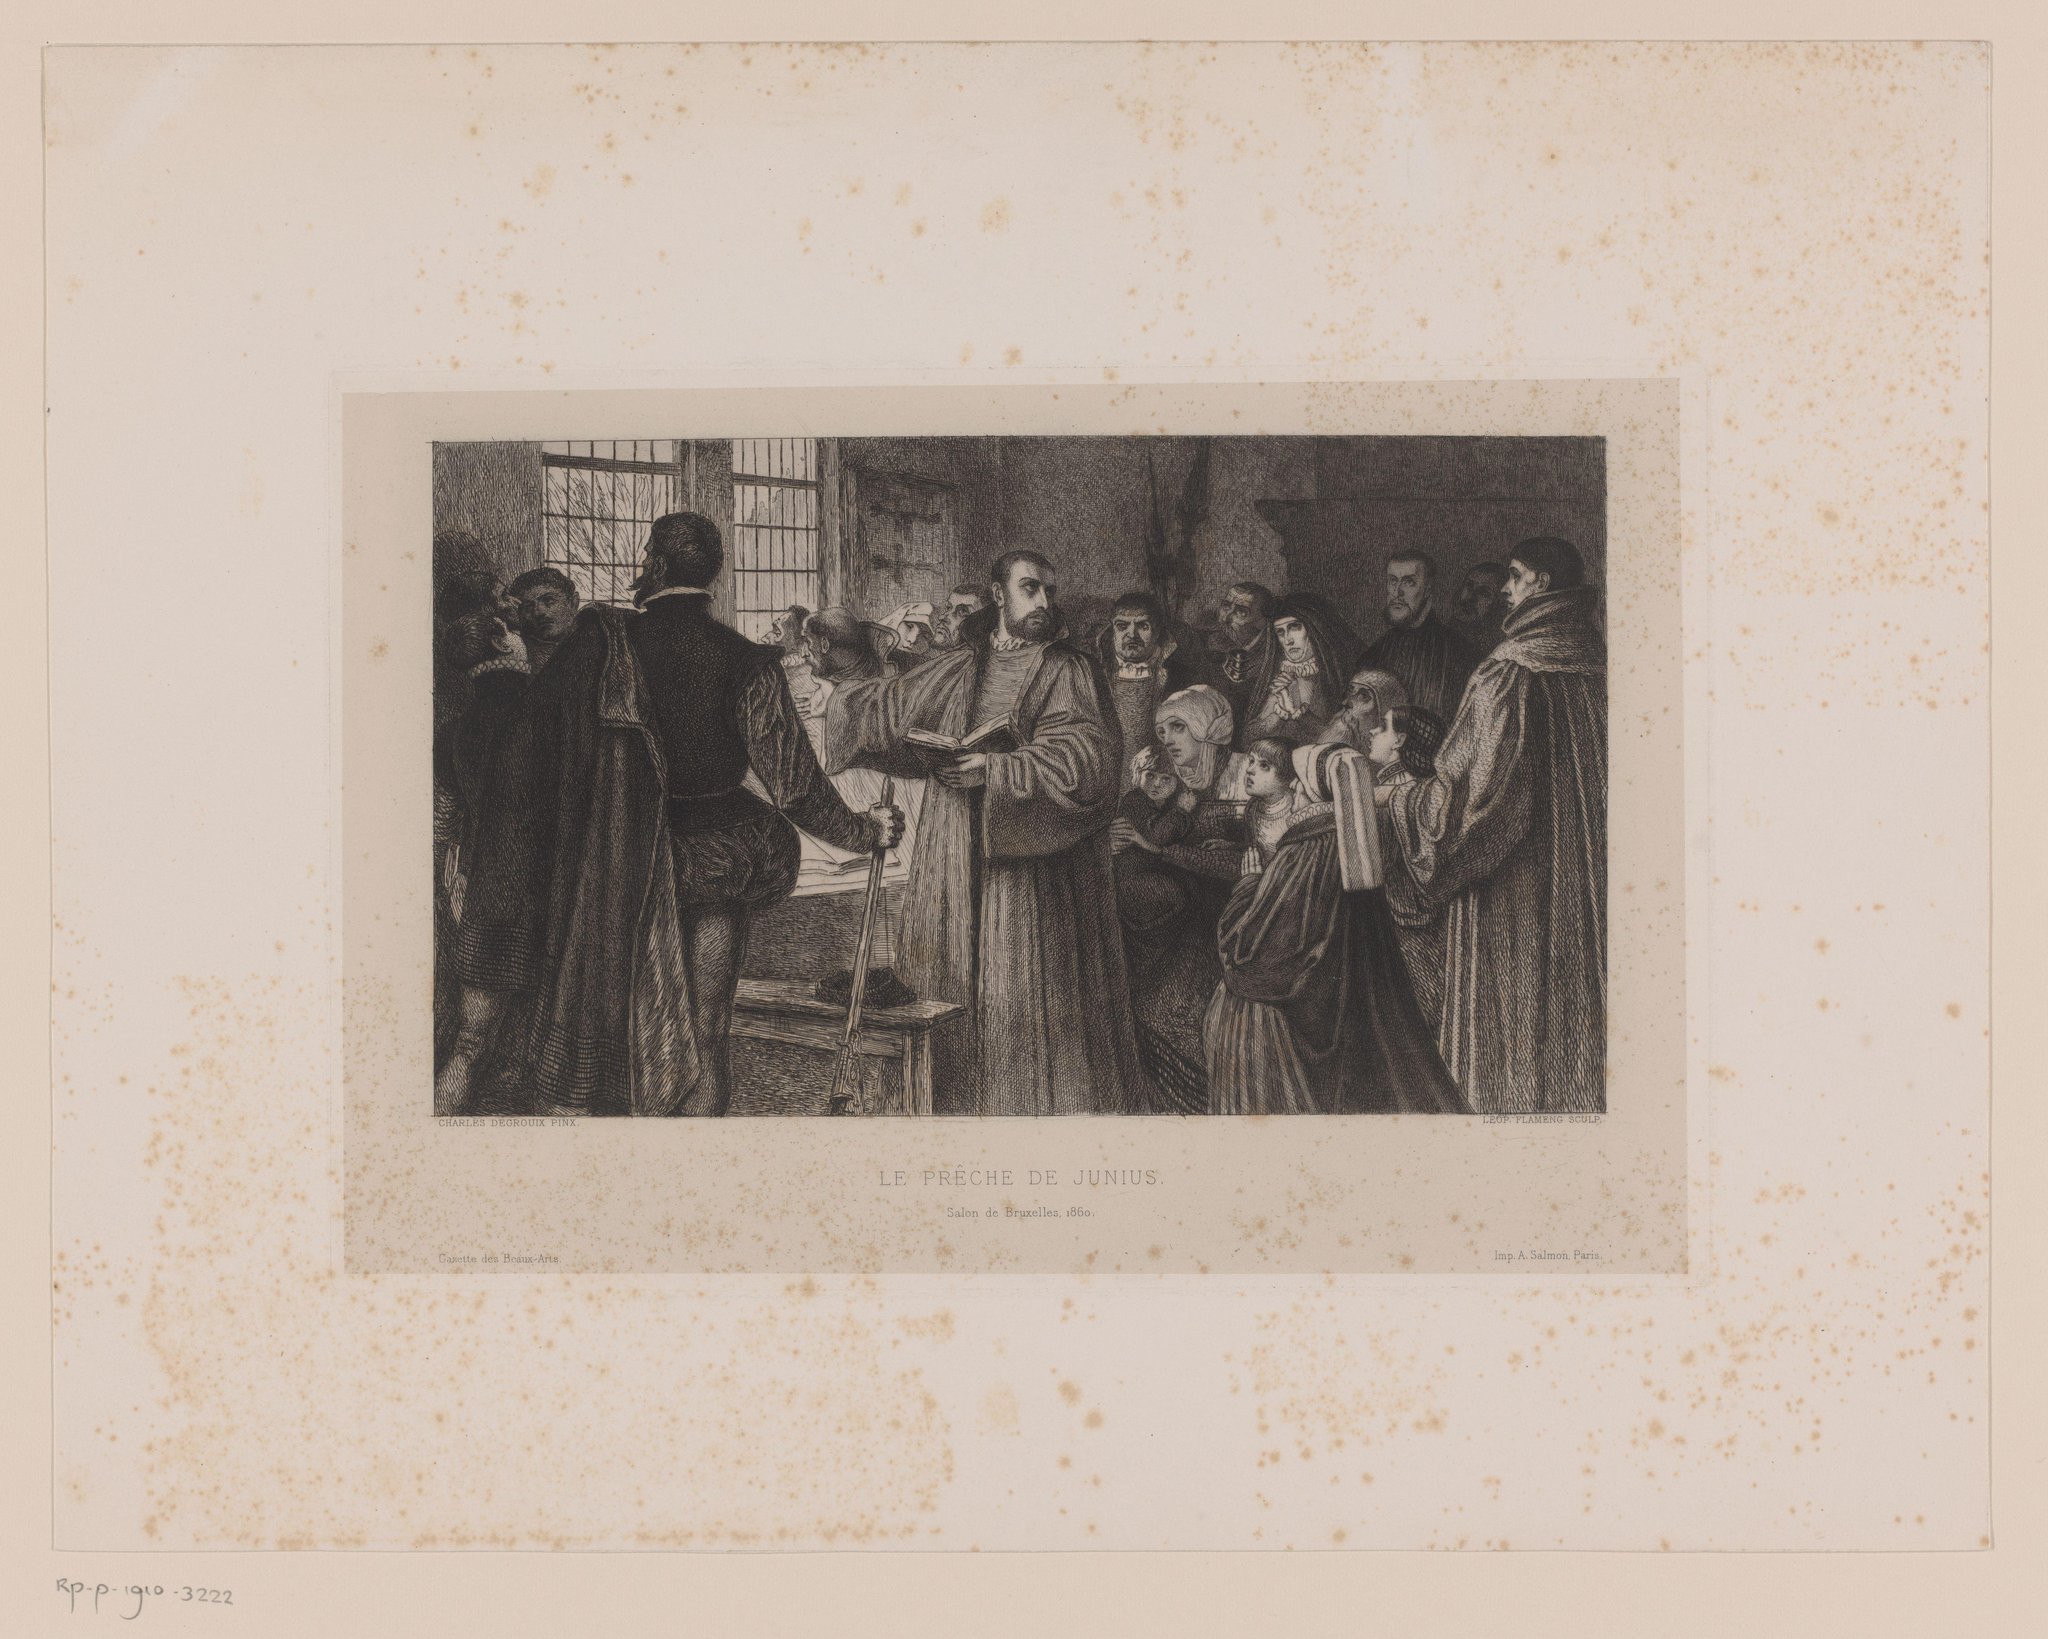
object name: print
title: Fanciscus Junius predikt heimelijk de hervorming in Antwerpen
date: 1860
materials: paper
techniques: etching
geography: paris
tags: franciscus junius (1624-1660), reformation (roman catholic church vs. protestantism), preaching (in general)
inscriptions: collector's mark: Lugt 2228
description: Prent uit: Gazette des beaux-arts (1860), dl. 4, p. 88.